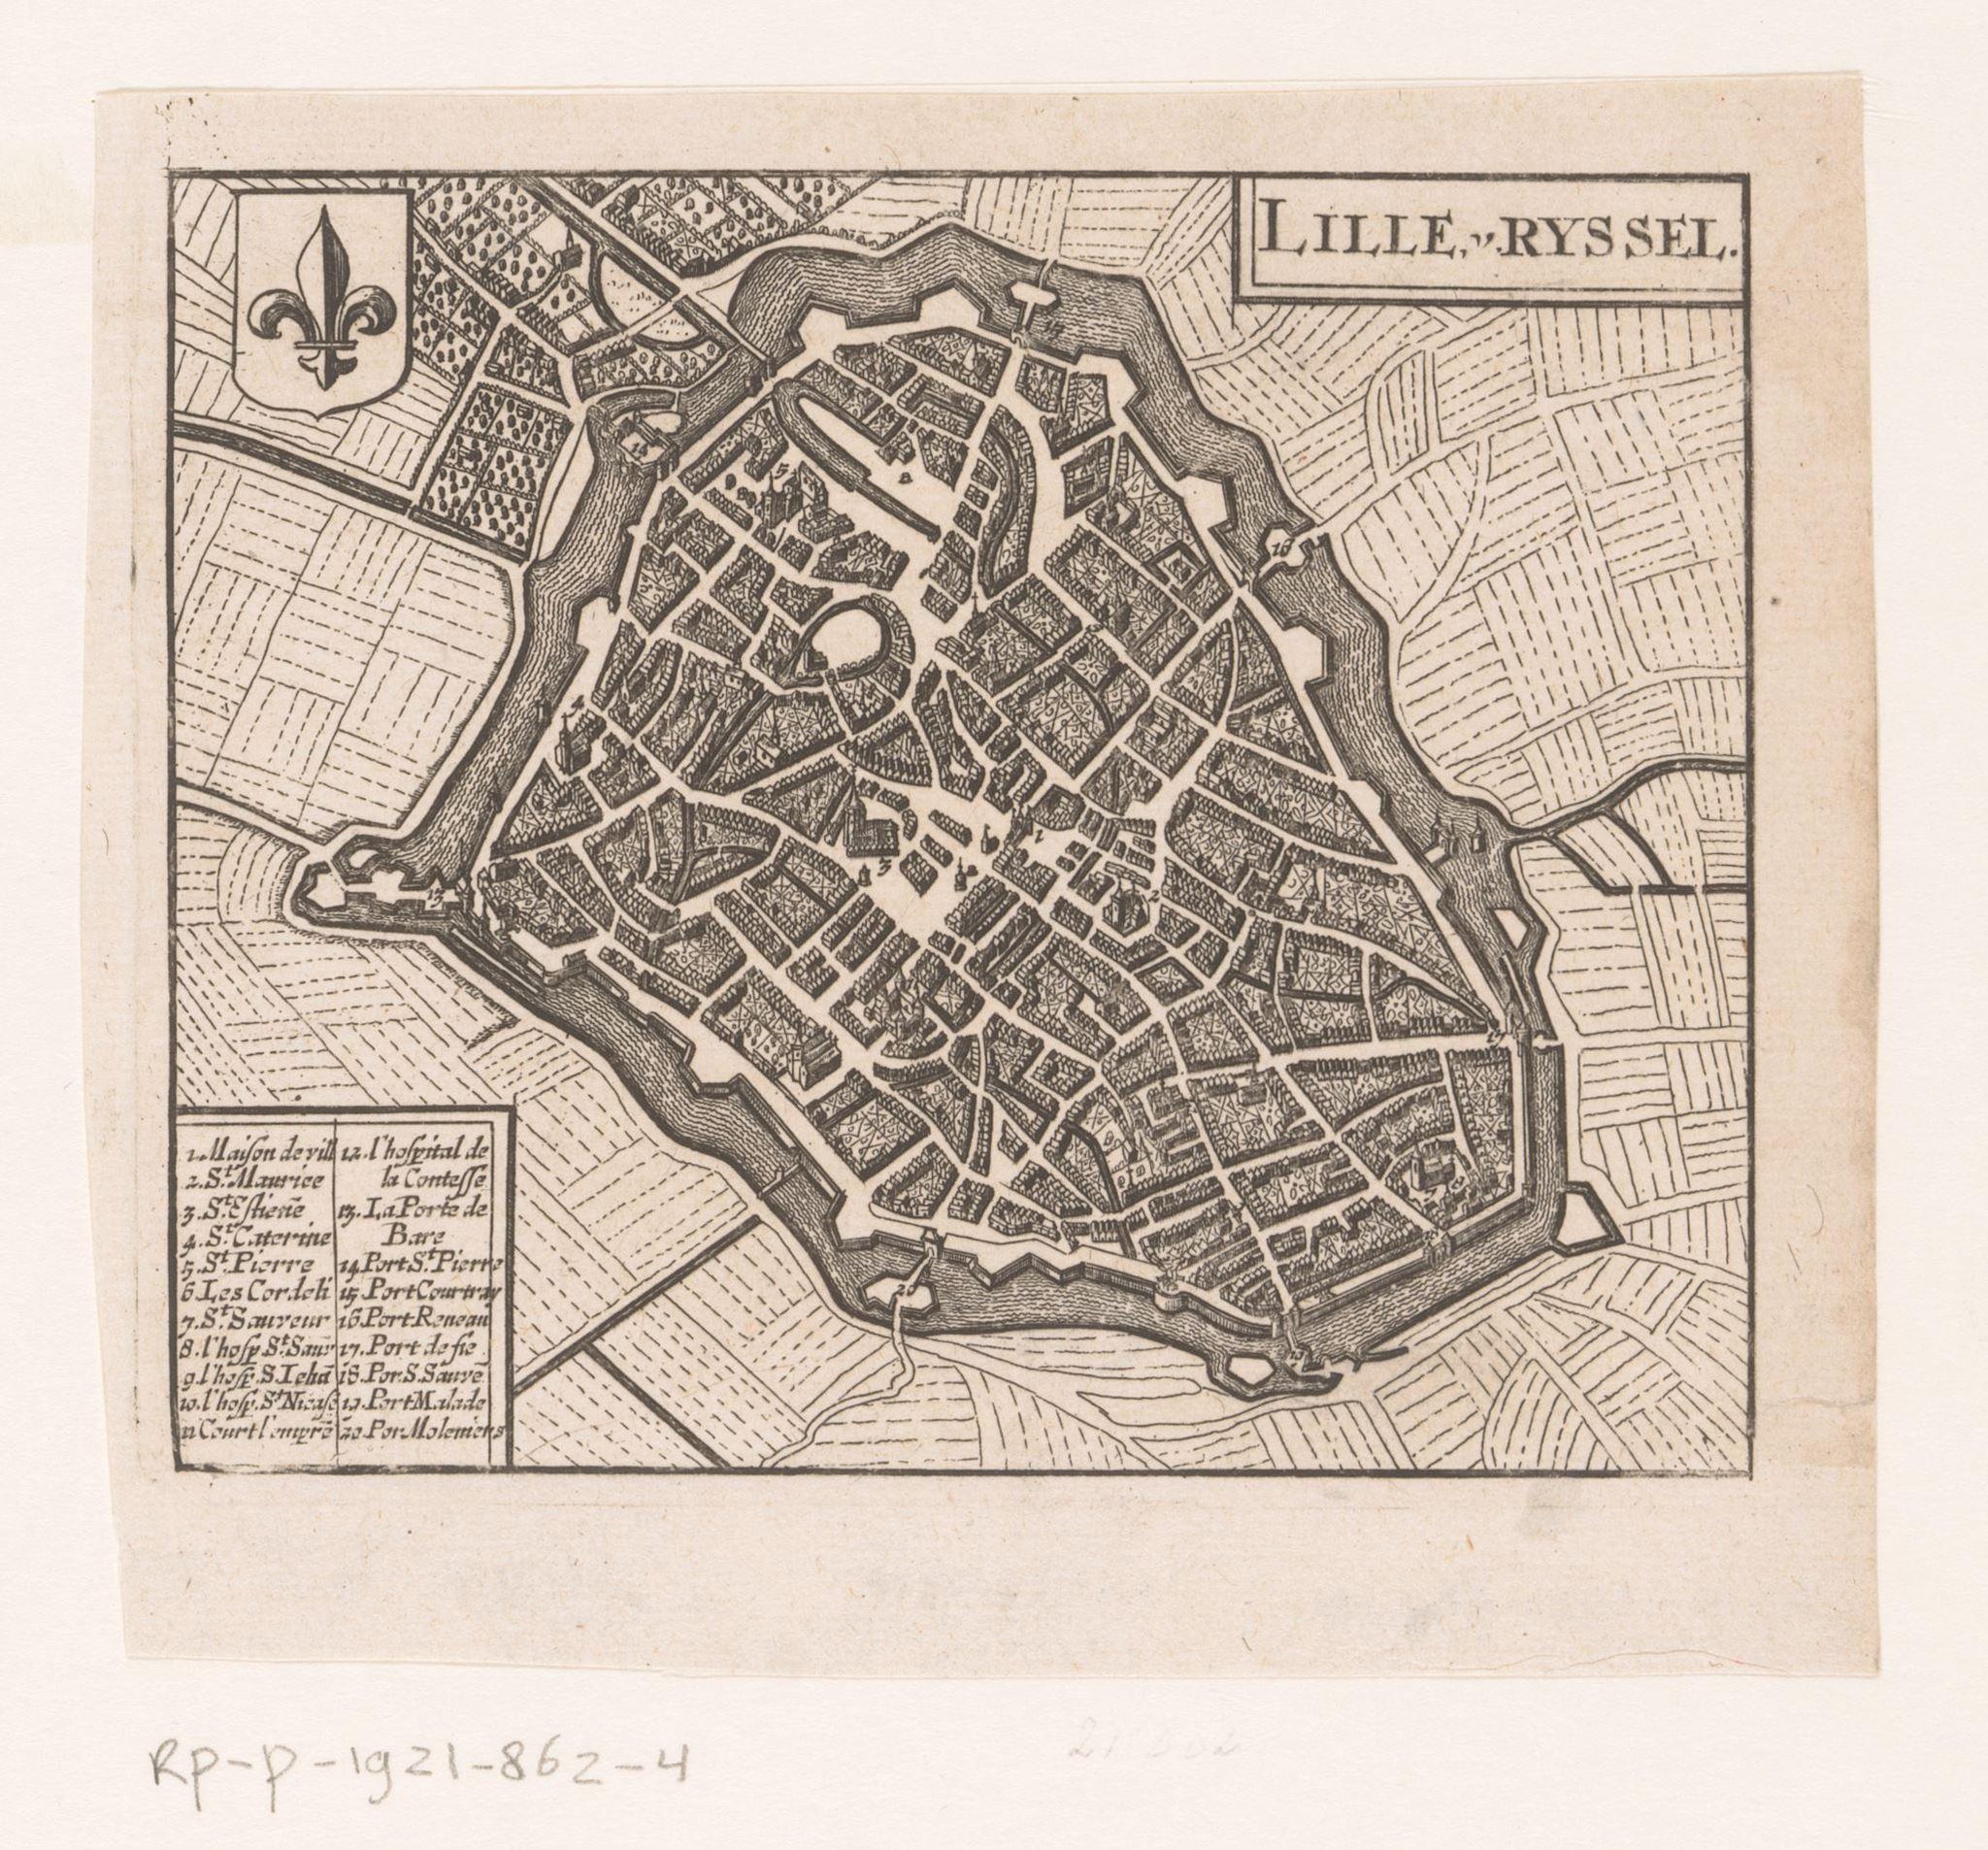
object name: print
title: Lille, v. Ryssel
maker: Anonymous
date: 1652-1662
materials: paper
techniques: etching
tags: fortified city, maps of cities, lille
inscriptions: collector's mark: Lugt 2228